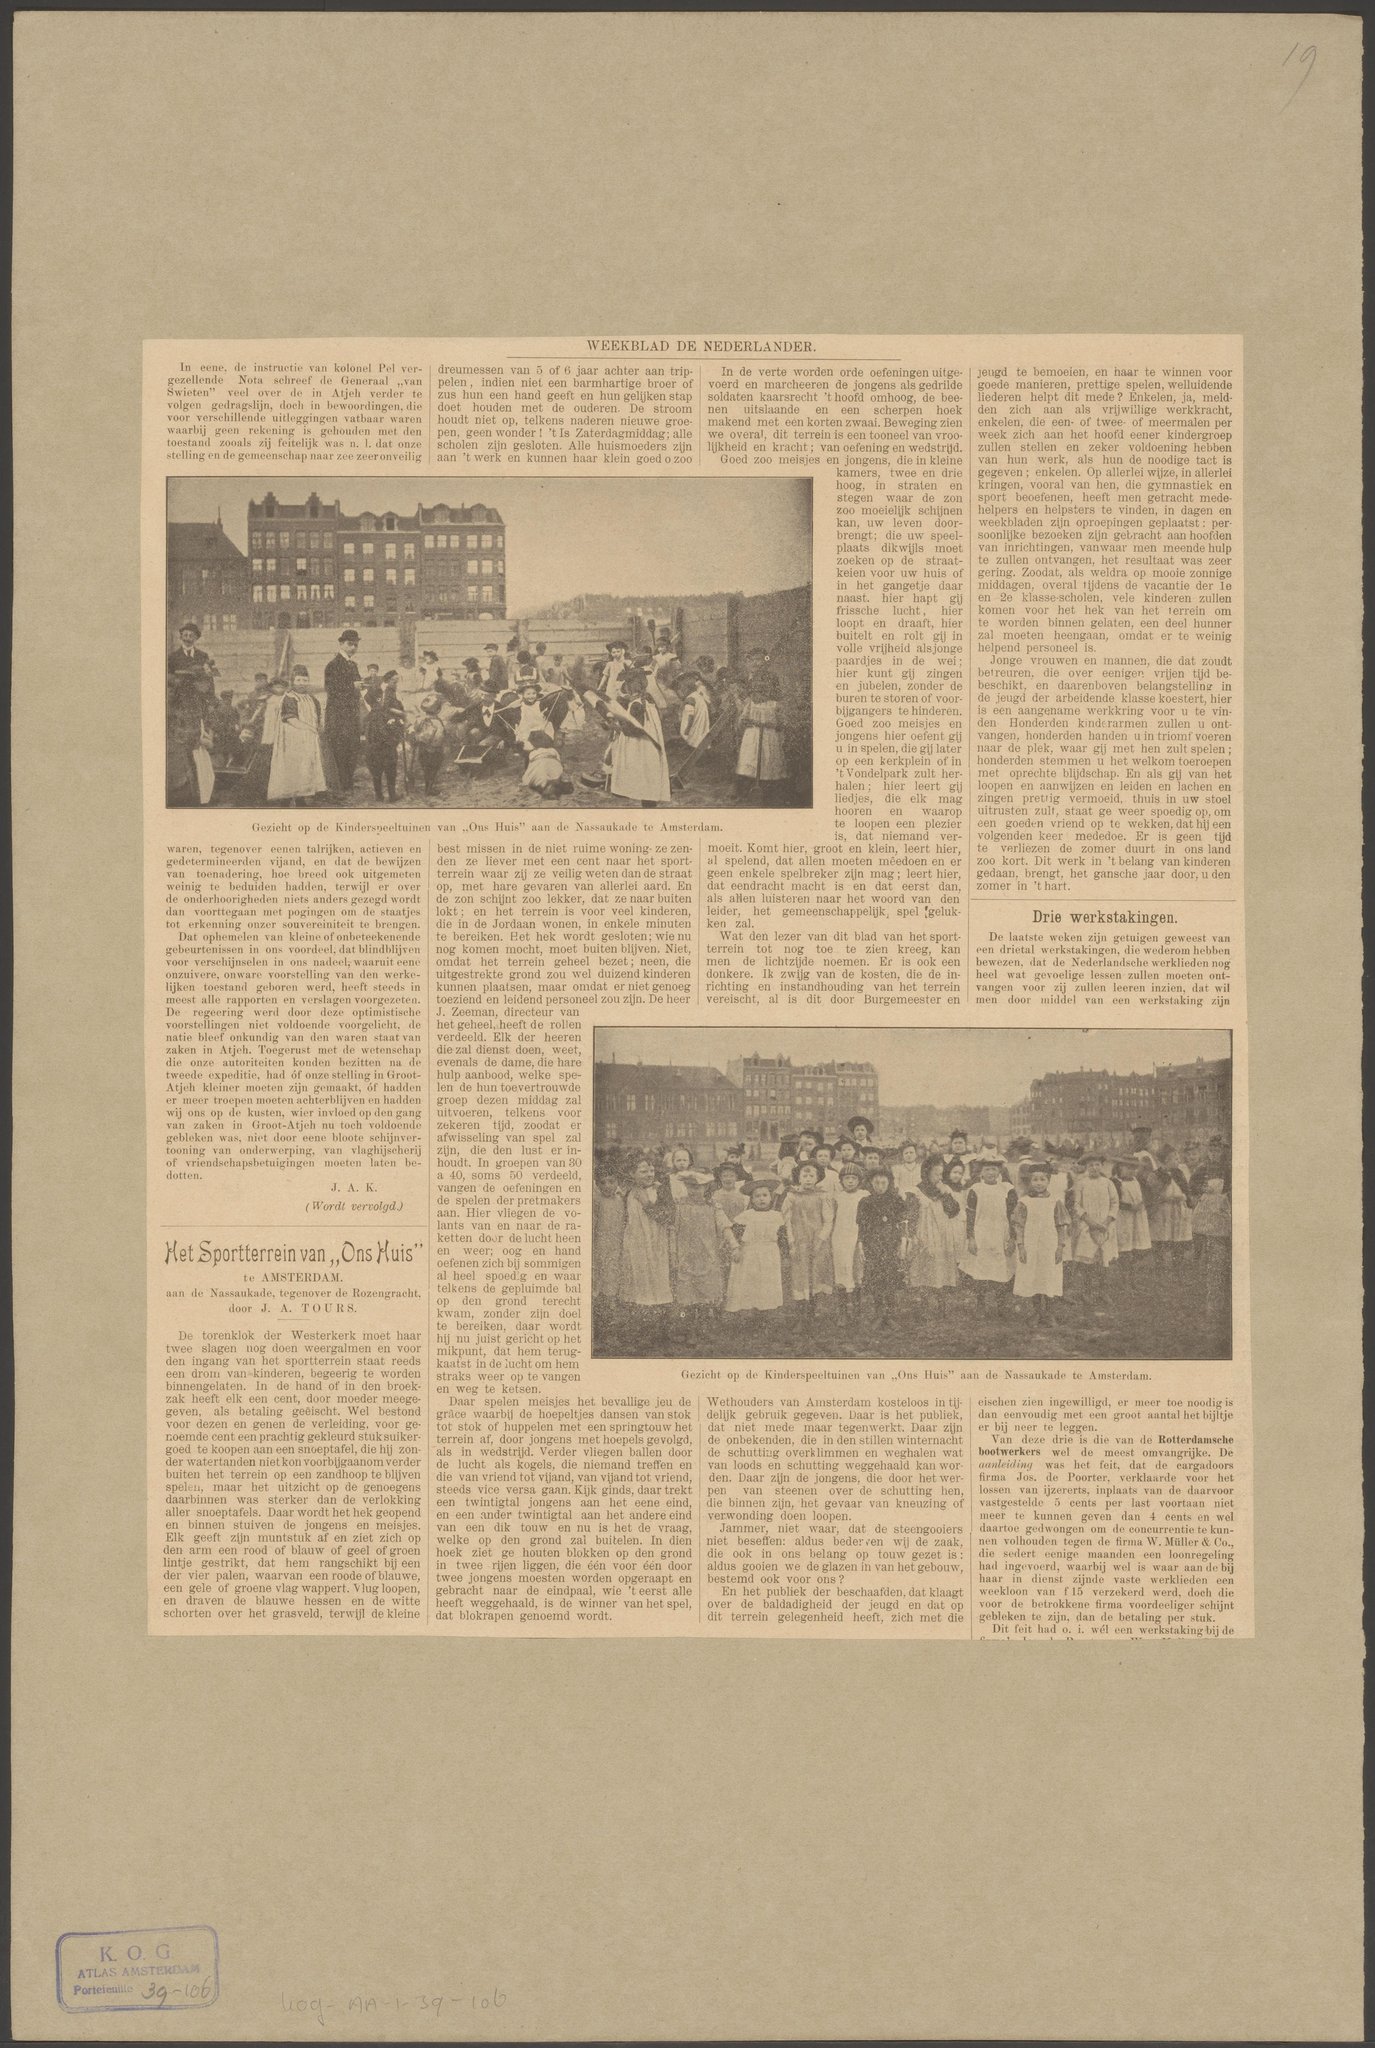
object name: article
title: Kinderen in de speeltuinen van Vereniging Ons Huis te Amsterdam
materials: paper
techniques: letterpress printing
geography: netherlands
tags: child, playground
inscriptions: collector's mark: Lugt 1641b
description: Onderwerpsrubriek binnen de Atlas Amsterdam: Armwezen en liefdadige instellingen: III. Verschillende gestichten en instellingen / Hofjes: Vereeniging Ons Huis.